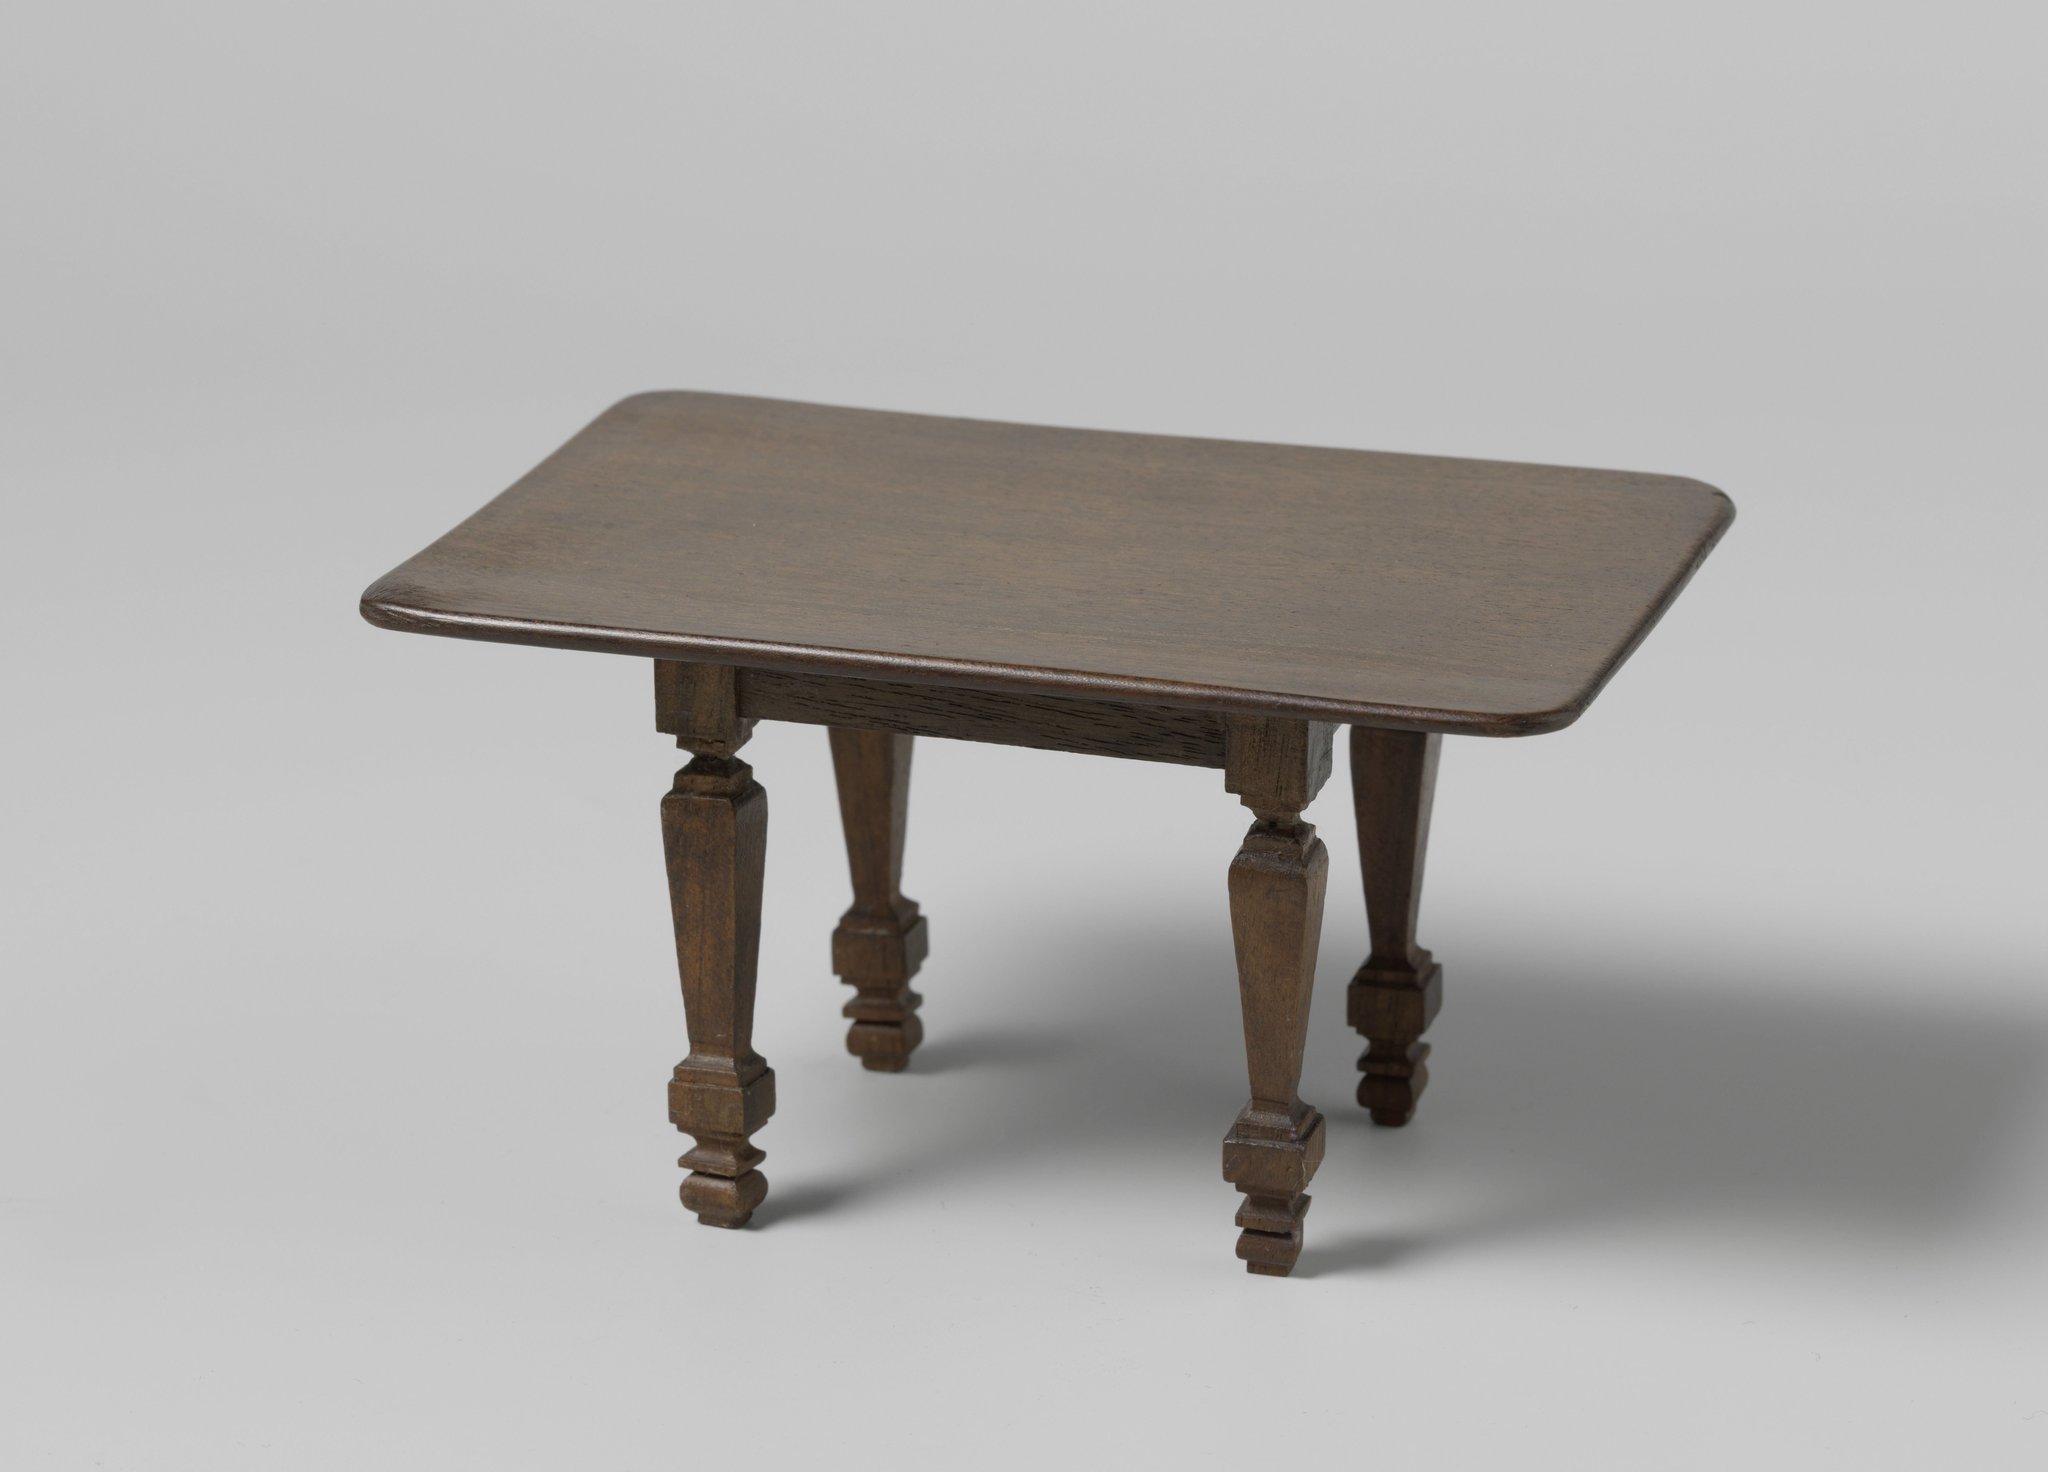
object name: miniature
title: Tafel met rechthoekig blad, op vier balustervormige, geprofileerde poten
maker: Anonymous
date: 1700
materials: wood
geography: amsterdam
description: Tafel met een rechthoekig mahoniehouten blad, het onderstel is vervaardigd van tropisch hardhout en bestaat uit vier balustervormige, geprofileerde poten, aan de bovenzijde met elkaar verbonden door regels.